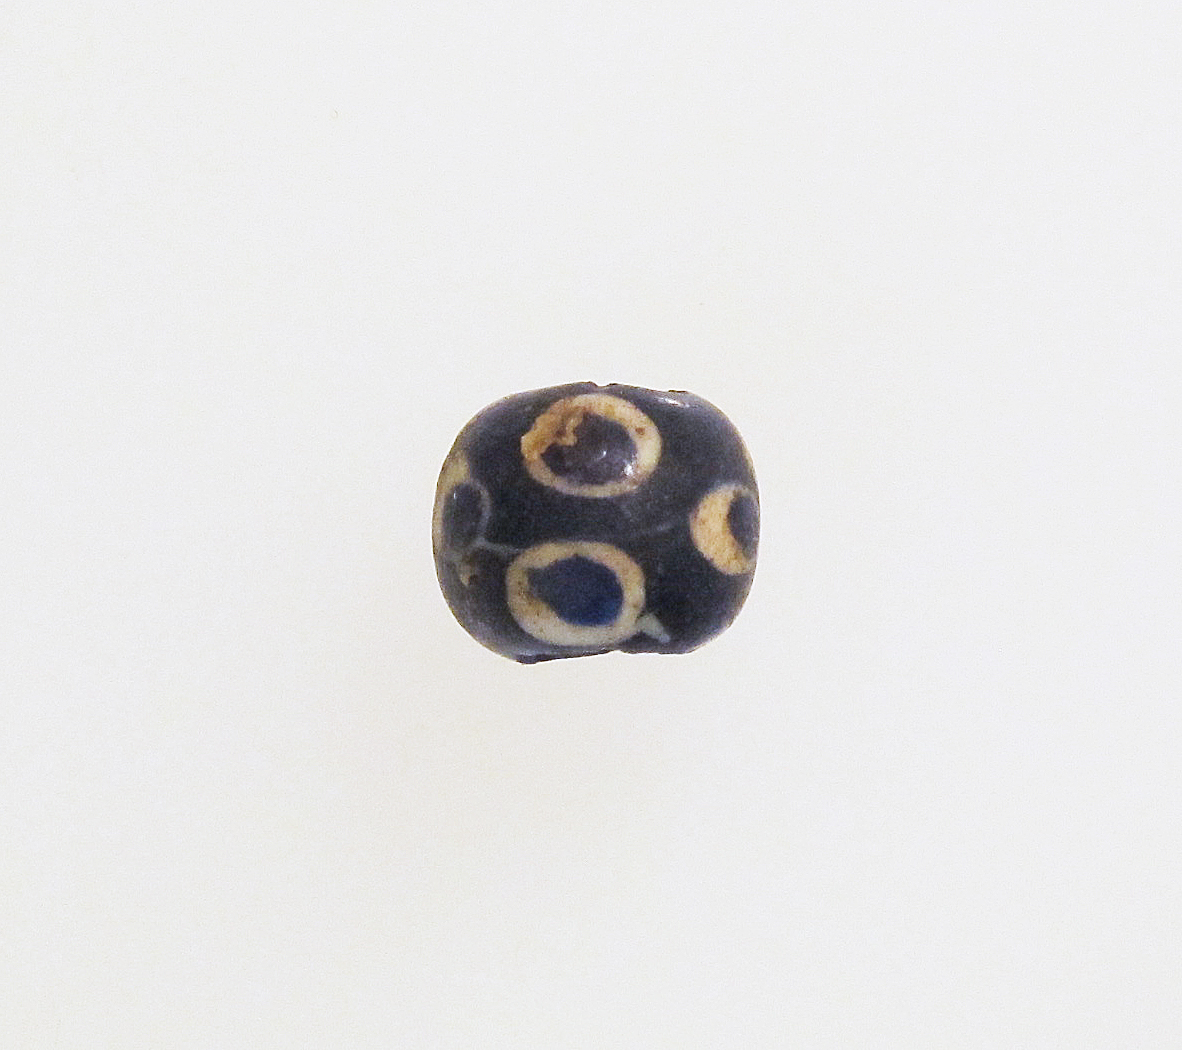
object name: bead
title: Glass eye bead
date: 7000 BCE-330 CE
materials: glass